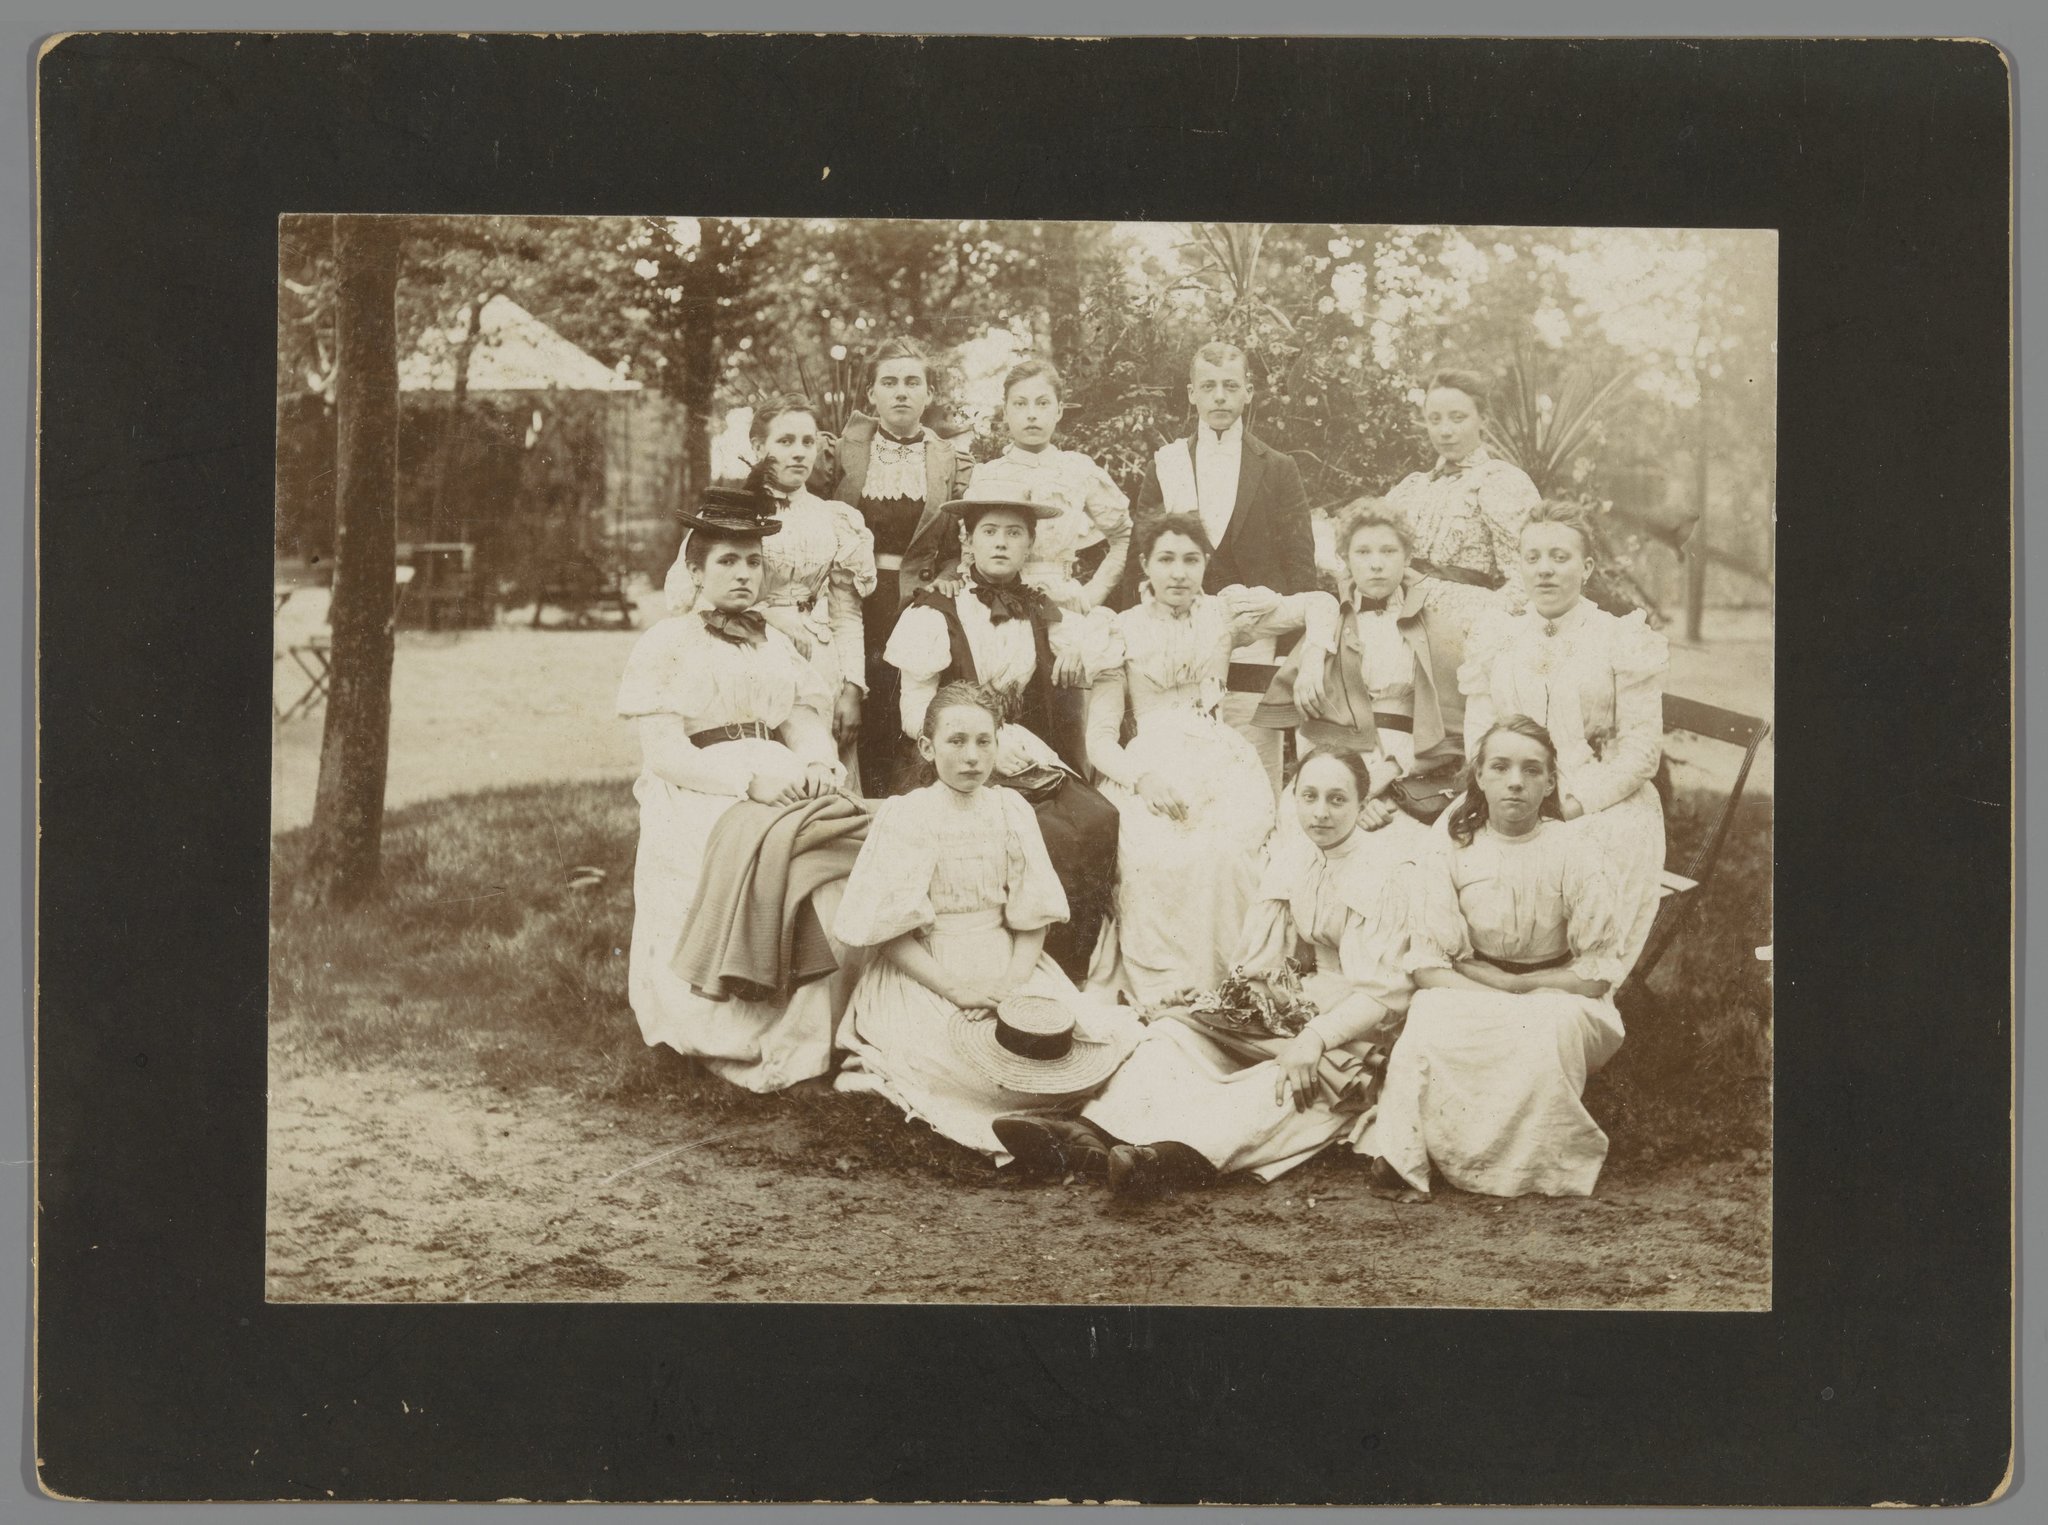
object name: photograph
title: Groepsportret van twaalf onbekende jonge vrouwen en een jonge man in een park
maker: Anonymous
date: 1890-1910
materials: paper, cardboard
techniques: gelatin silver print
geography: netherlands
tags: anonymous historical persons portrayed in a group, in a group-portrait